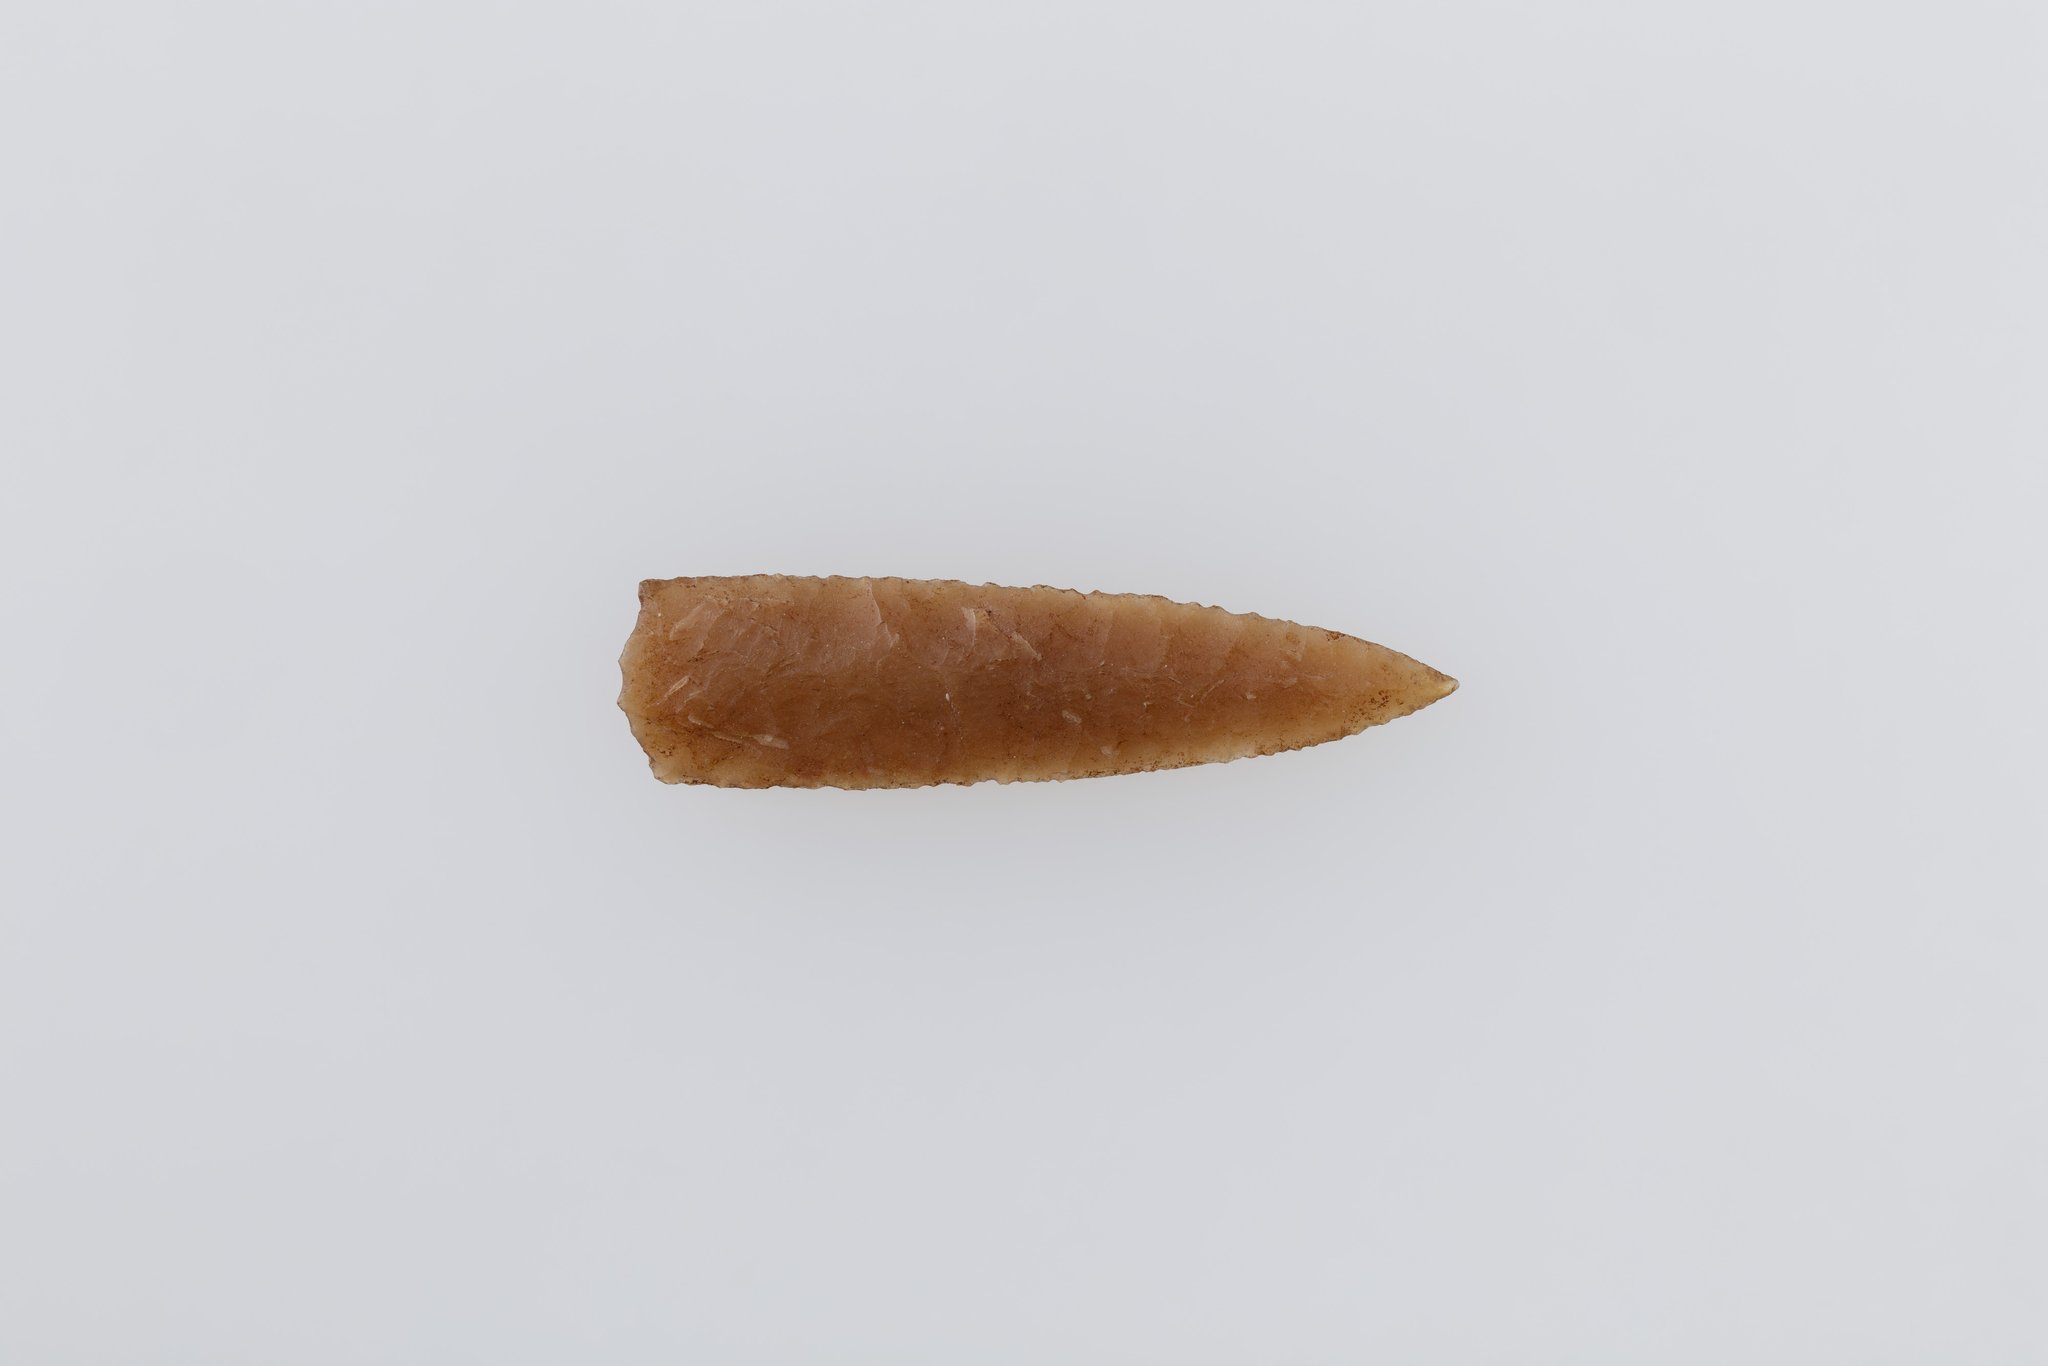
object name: arrowhead, projectile point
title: Projectile Point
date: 3100-2649 BCE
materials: stone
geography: egypt